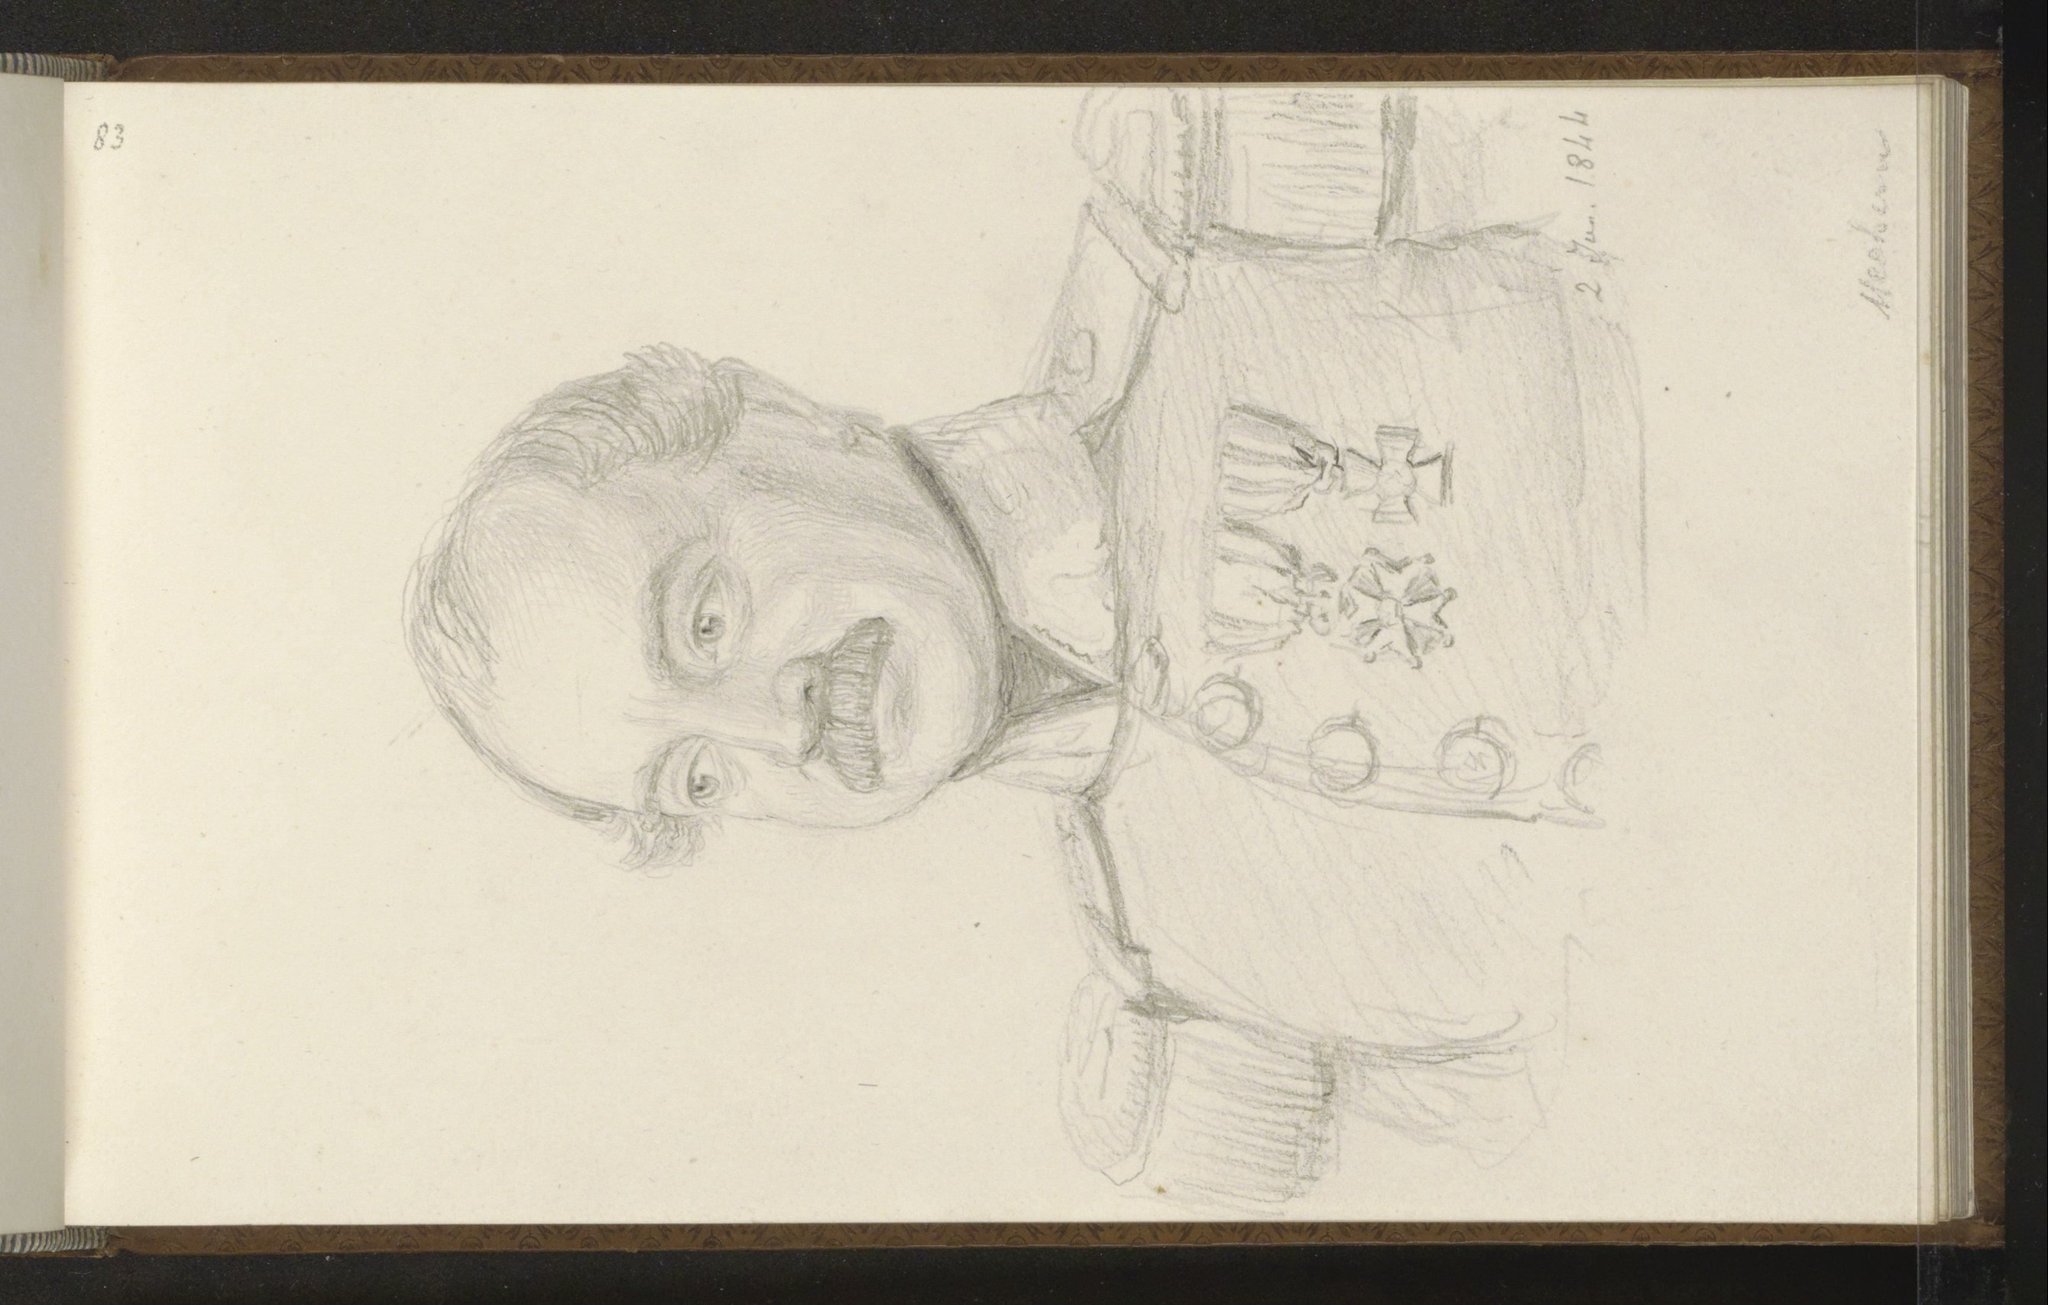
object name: sketchbook leaf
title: Portret van een militair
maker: christian heinrich gottlieb steuerwald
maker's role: draughtsman, print maker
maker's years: 1802-1874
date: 1806-1844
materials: paper, pencil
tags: (military) uniforms, historical persons (portraits and scenes from the life)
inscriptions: date and inscription: ‘2 Juni 1844/ Meebu[...]n’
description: De man heeft twee ordekruizen opgespeld. Bladzijde 83 uit een schetsboek met 188 bladzijden.